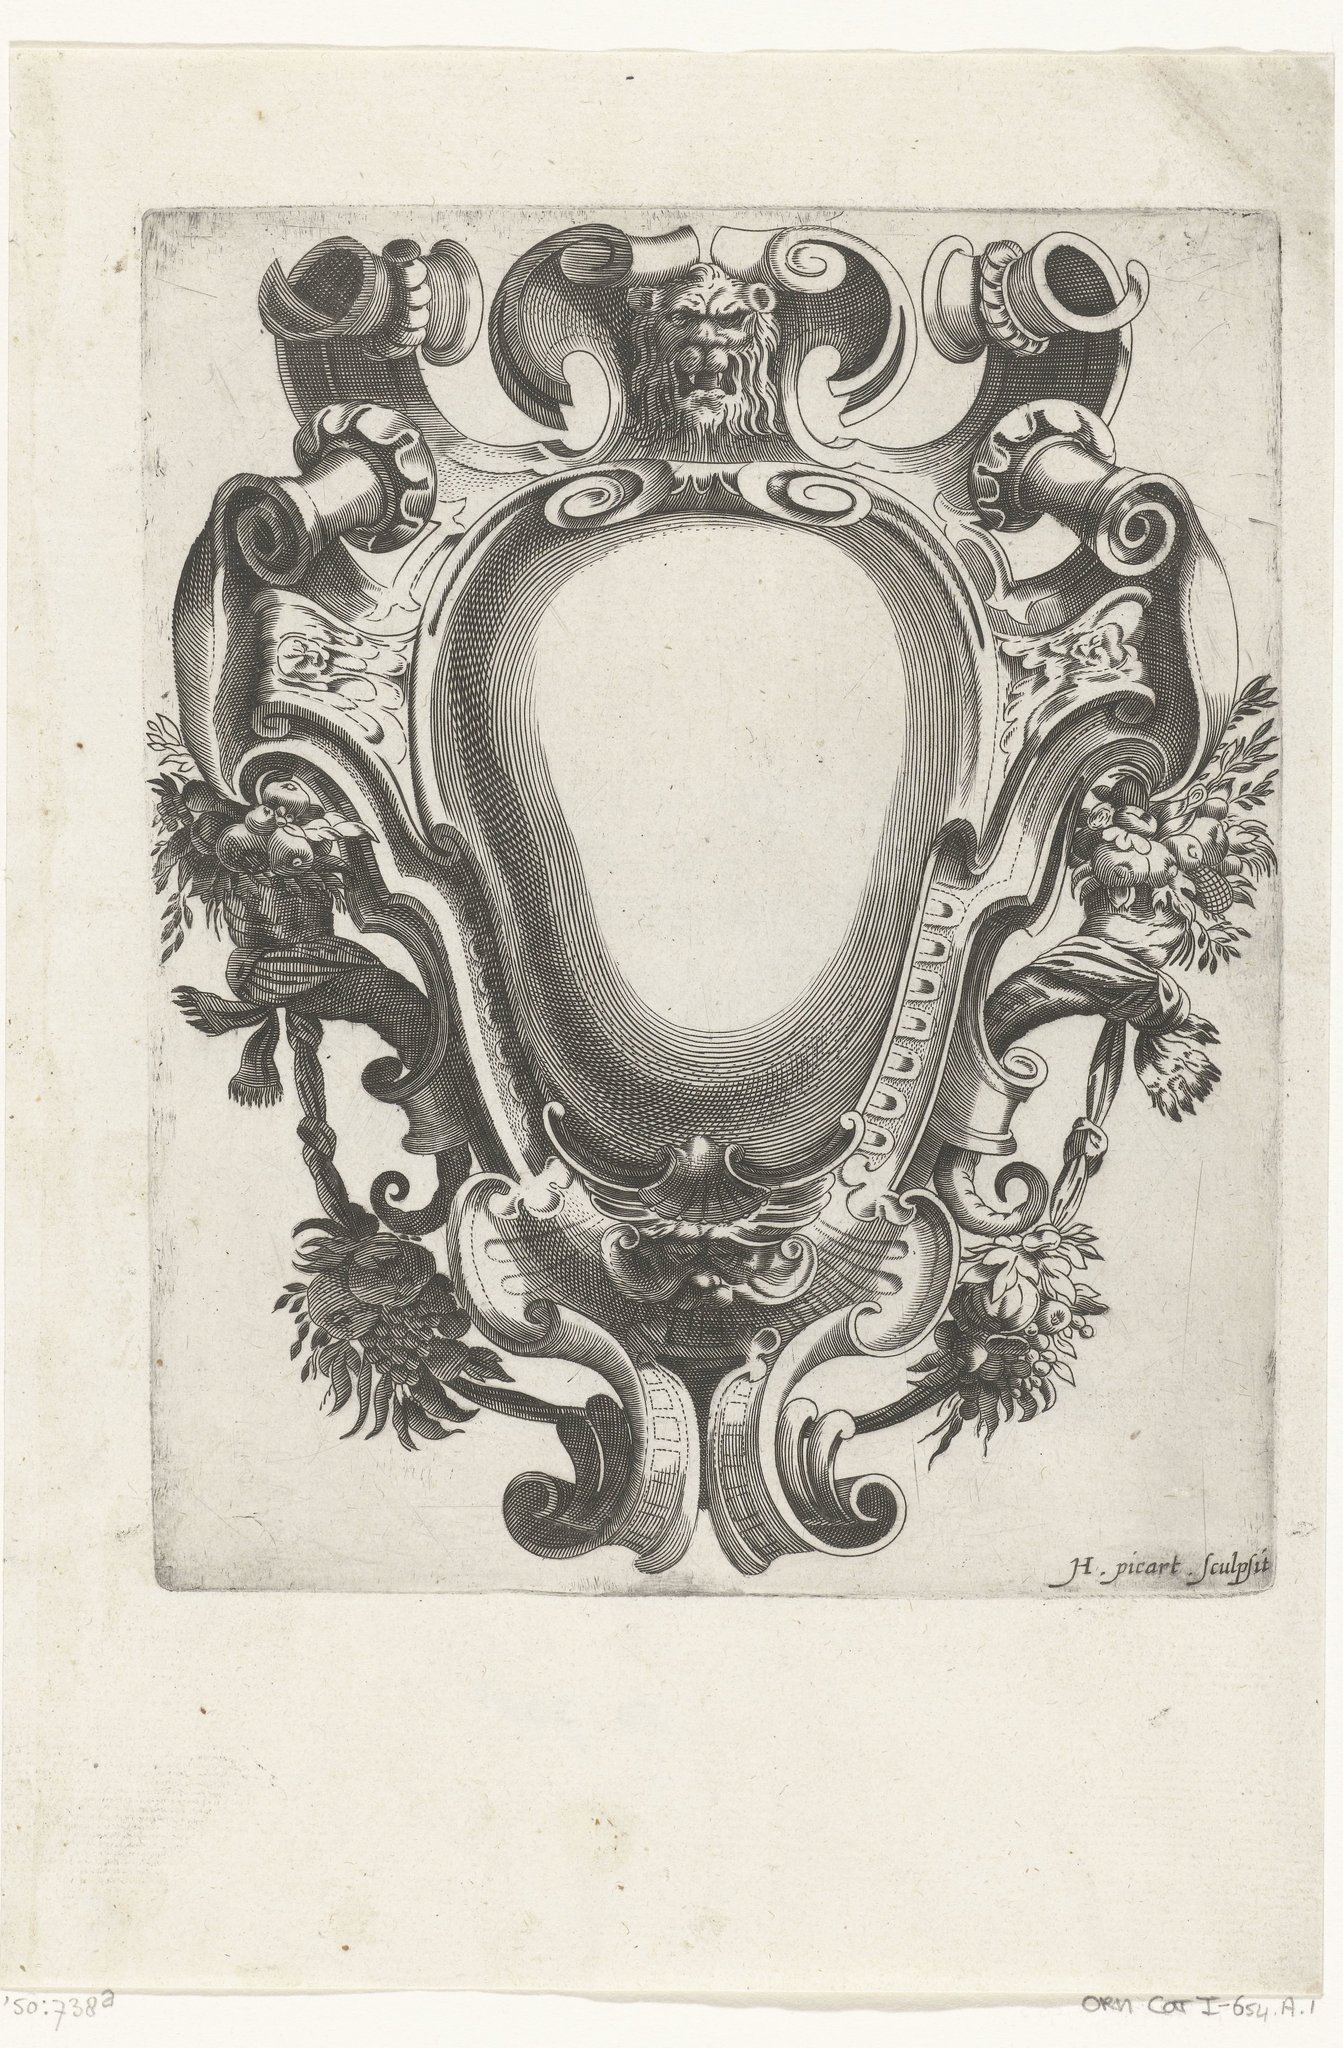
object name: print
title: Cartouches in omlijstingen van rolwerk met grotesken, guirlandes en mascarons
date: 1628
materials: paper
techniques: engraving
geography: france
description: Tegenzijdige kopie naar blad 1 uit serie met cartouches in omlijstingen van rolwerk met grotesken, guirlandes en mascarons uitgegeven door Pierre Mariette.